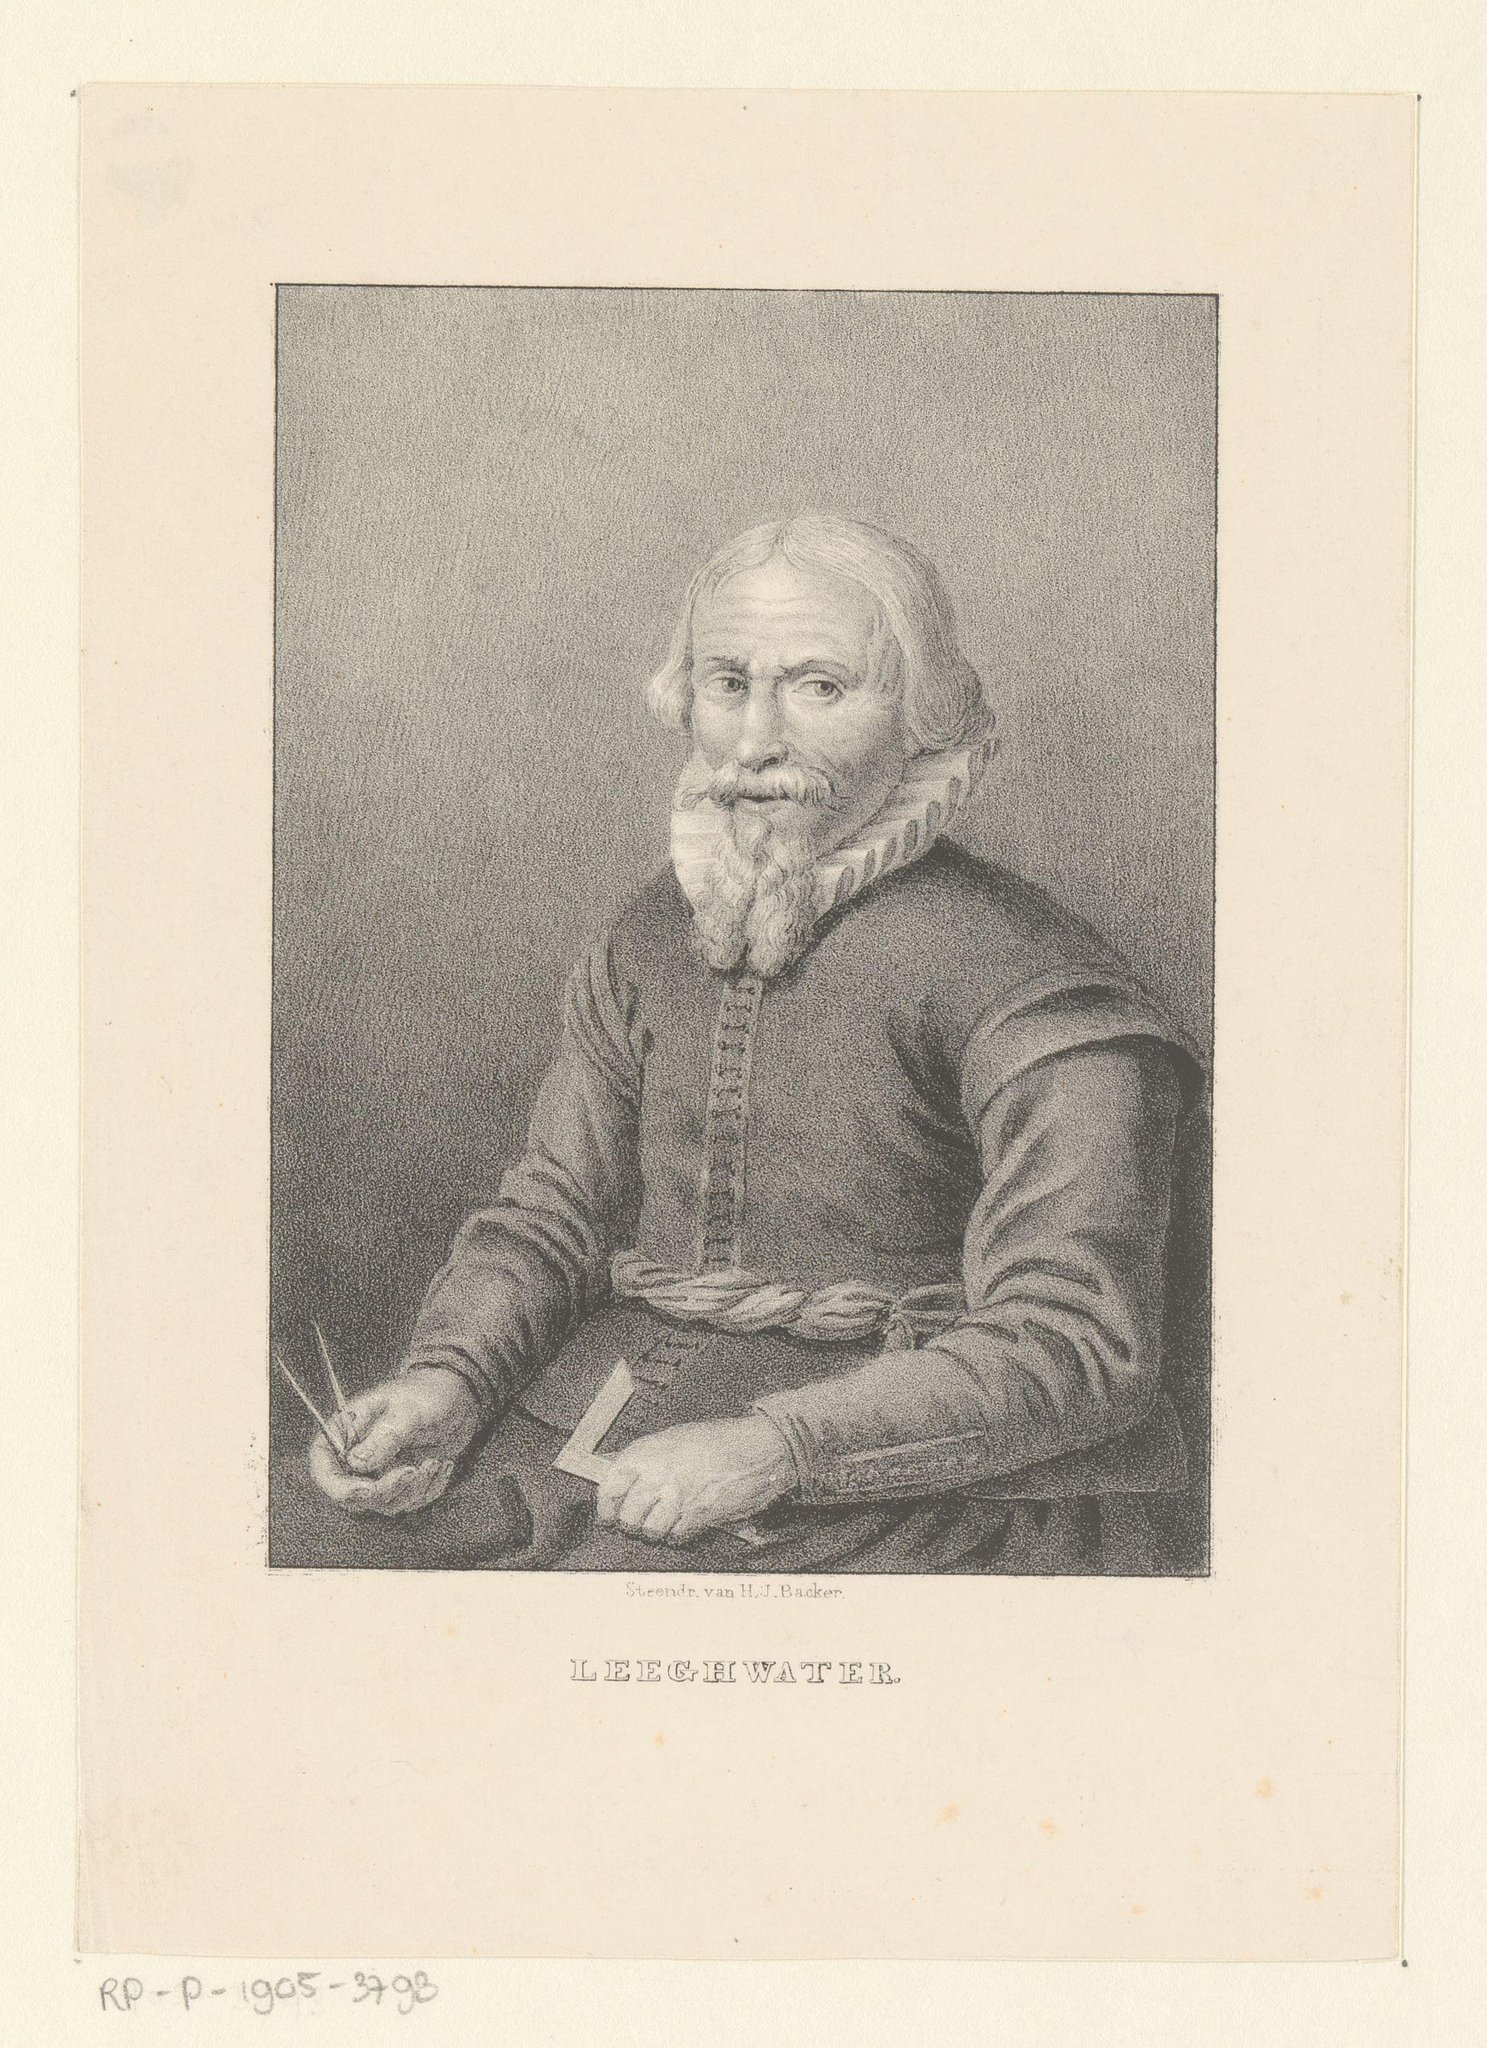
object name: print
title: Portret van de waterbouwkundige Jan Adriaanszoon Leeghwater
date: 1822-1845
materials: paper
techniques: lithograph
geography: dordrecht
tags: jan adriaensz. leeghwater, neck-gear ~ clothing (with name), historical persons, measuring-instruments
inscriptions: collector's mark: Lugt 2228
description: De geportretteerde draagt een kleine plooikraag. In zijn linkerhand heeft hij een passer, in zijn rechterhand een winkelhaak.